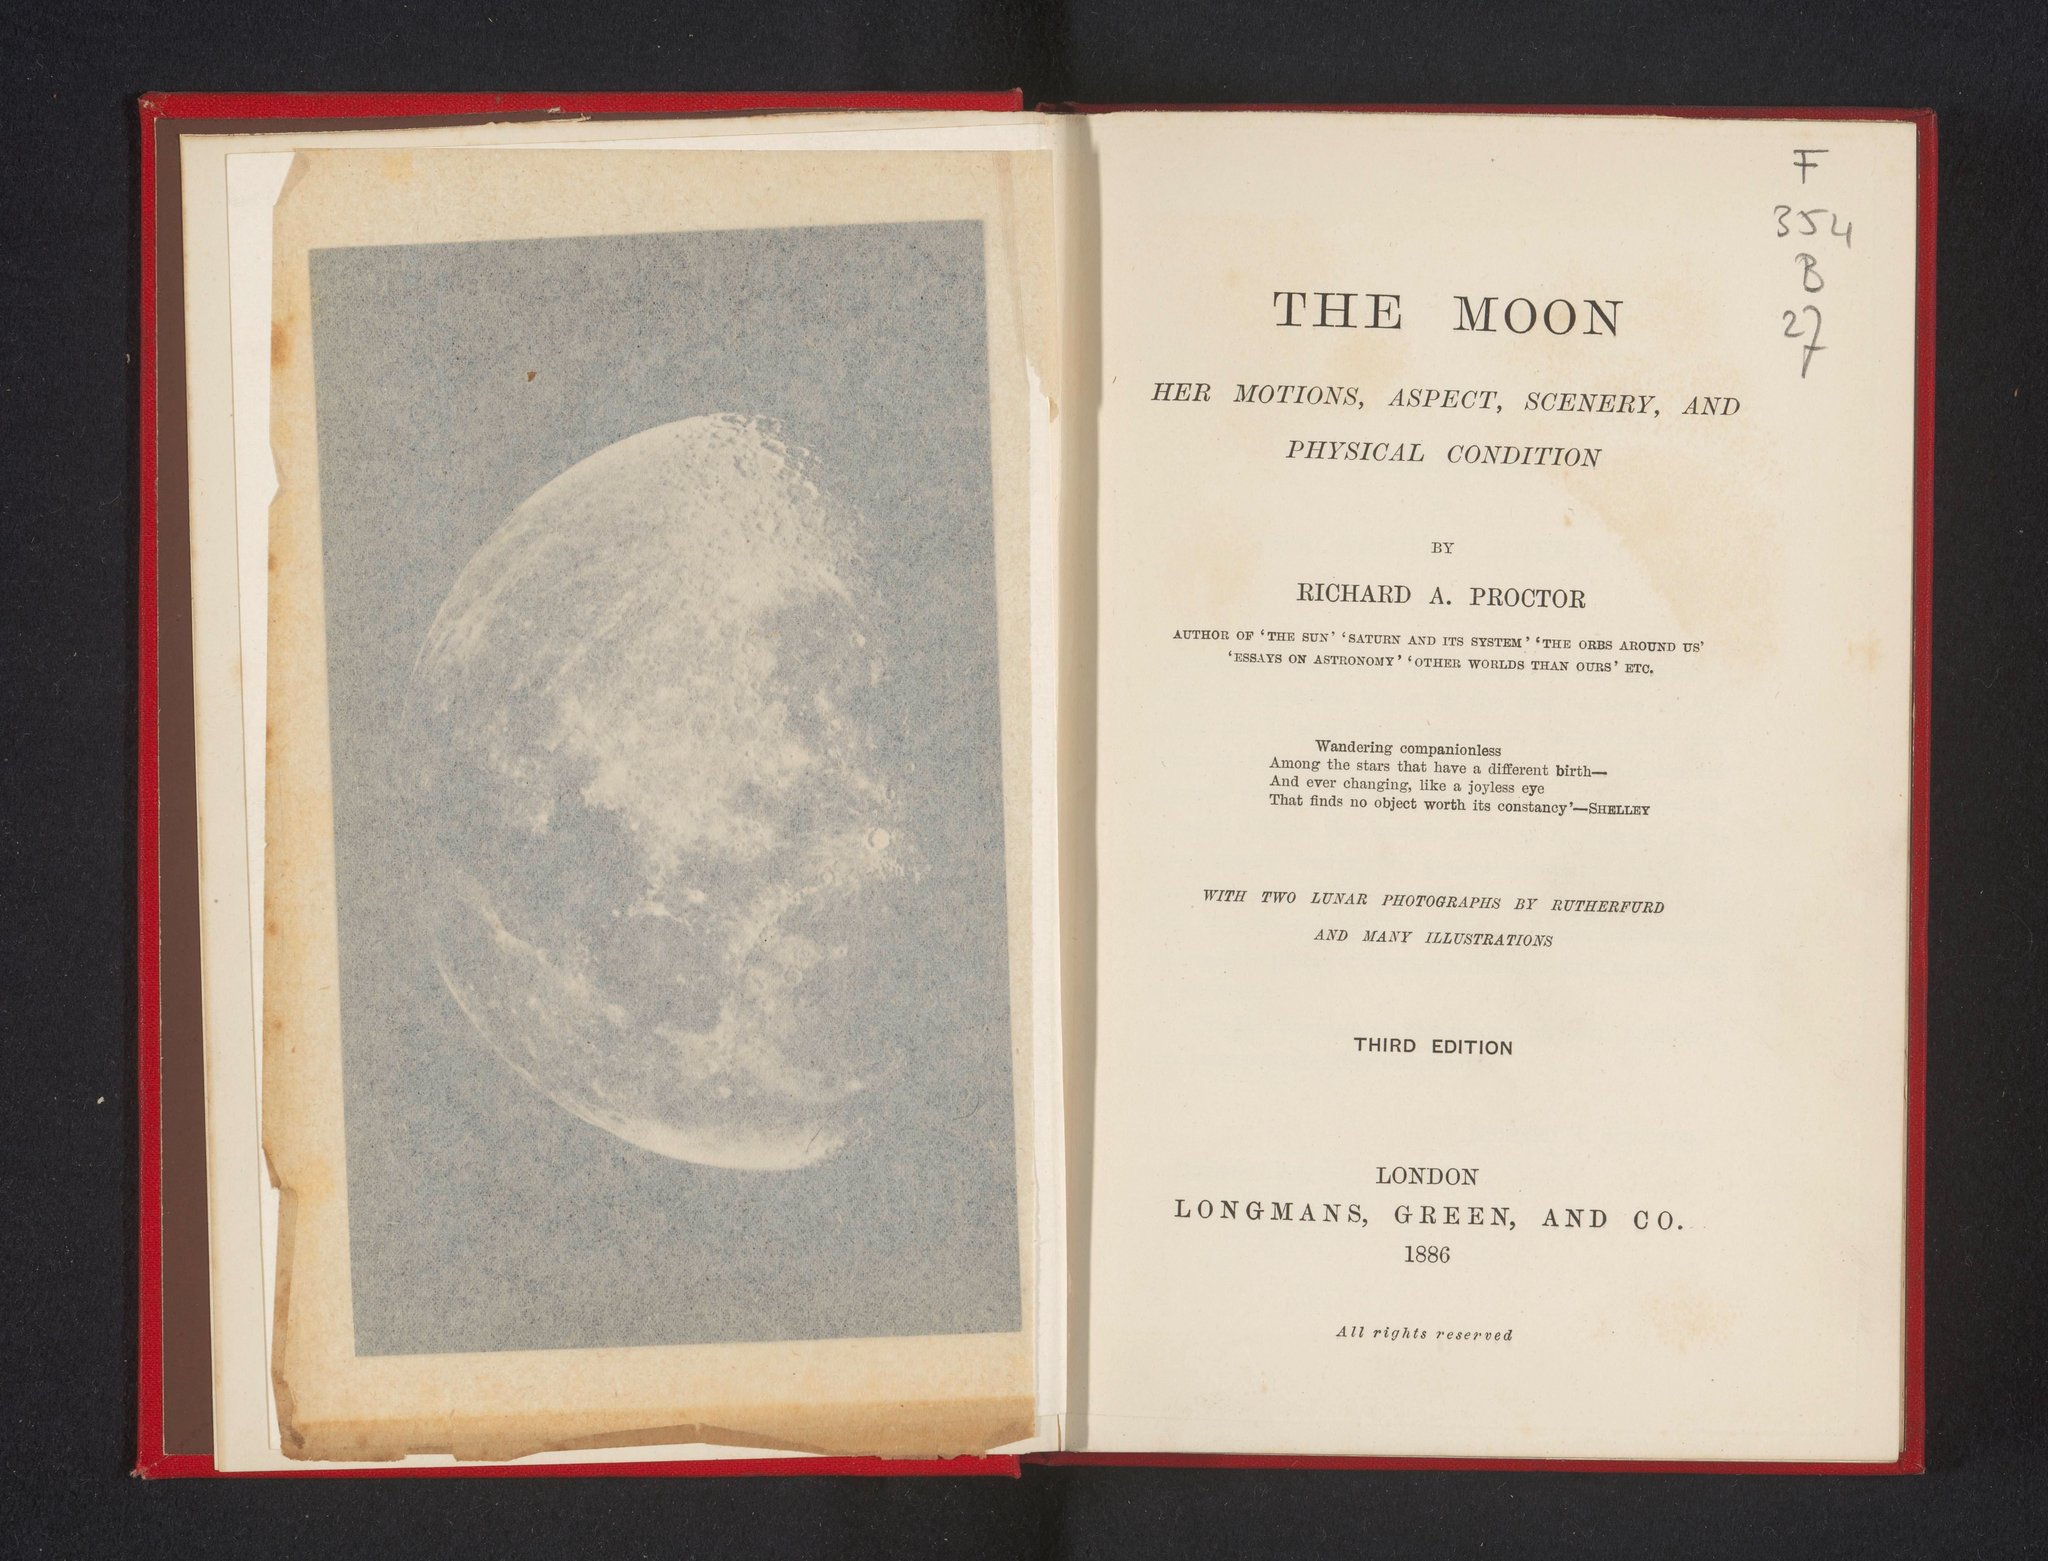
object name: book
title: The moon, her motions, aspect, scenery, and physical condition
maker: richard anthony proctor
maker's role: astronoom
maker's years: 1837-1888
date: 1886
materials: cardboard, linen, paper, photographic support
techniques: photograph, lithograph, printing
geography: london